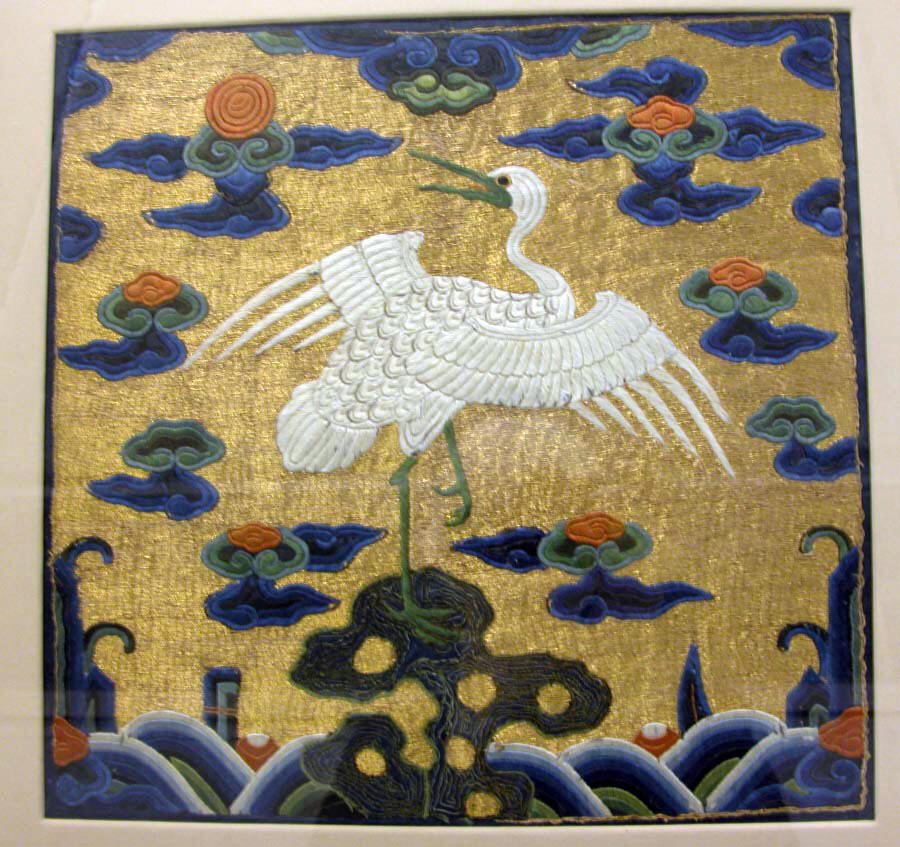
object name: rank badge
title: Rank Badge with Egret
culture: chinese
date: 1701-1733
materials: feather, metal thread, silk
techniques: embroidery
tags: birds